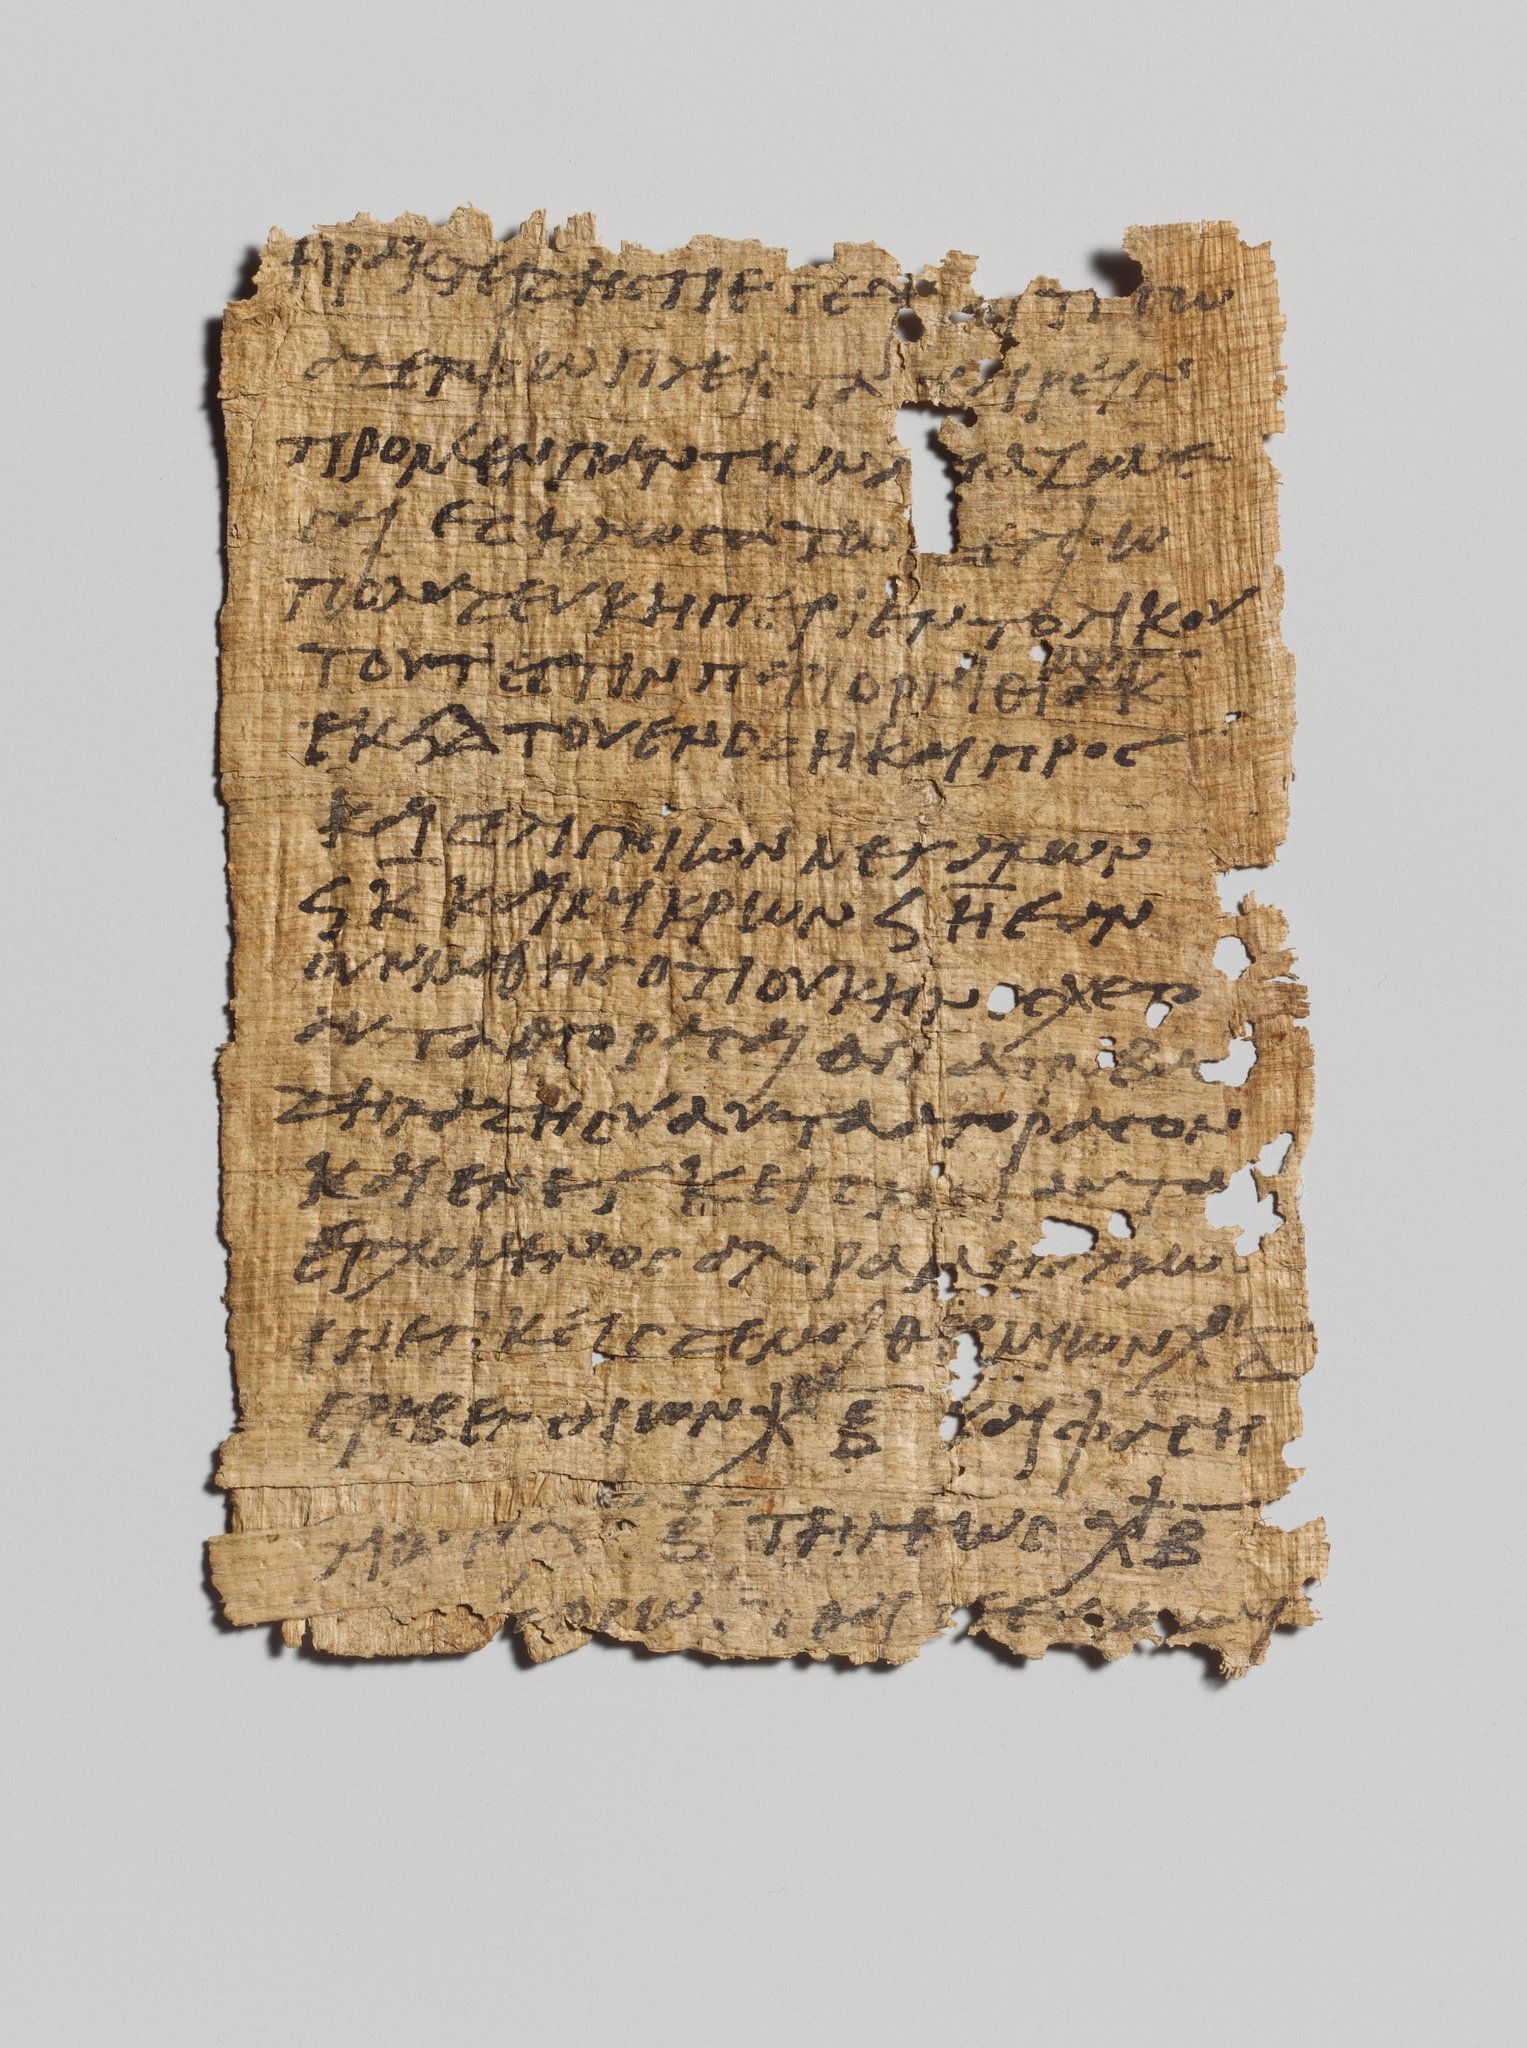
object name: papyrus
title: Papyrus letter in Greek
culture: roman, egyptian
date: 201-233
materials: papyrus